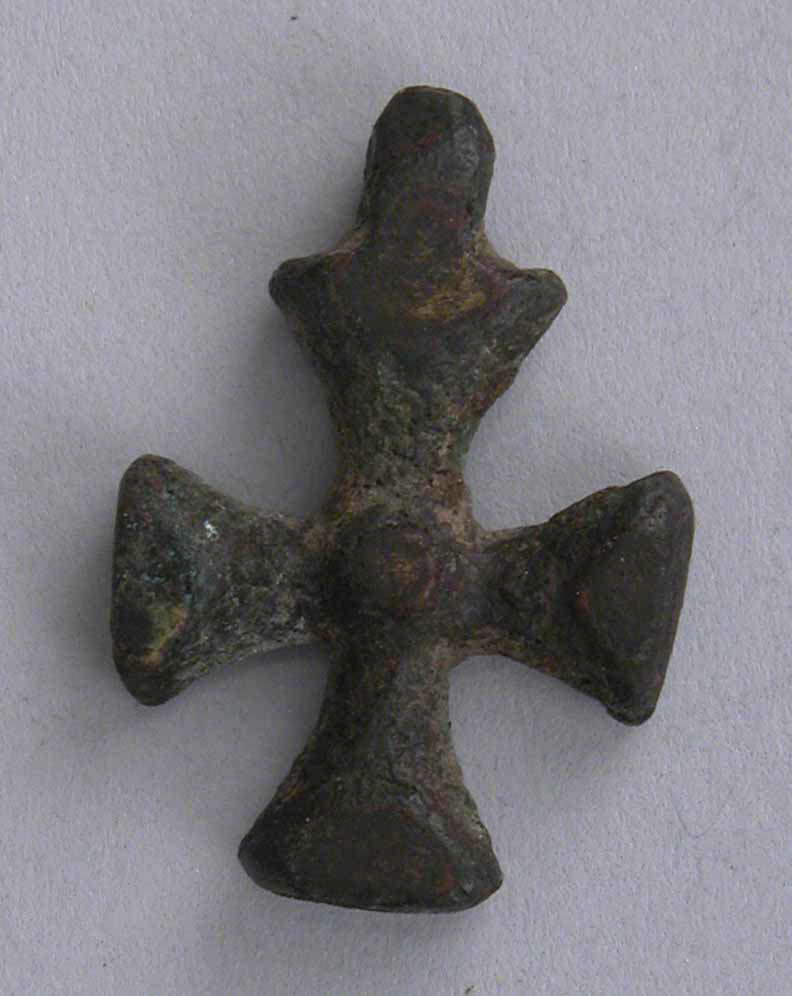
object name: cross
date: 201-1200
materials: bronze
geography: egypt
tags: cross